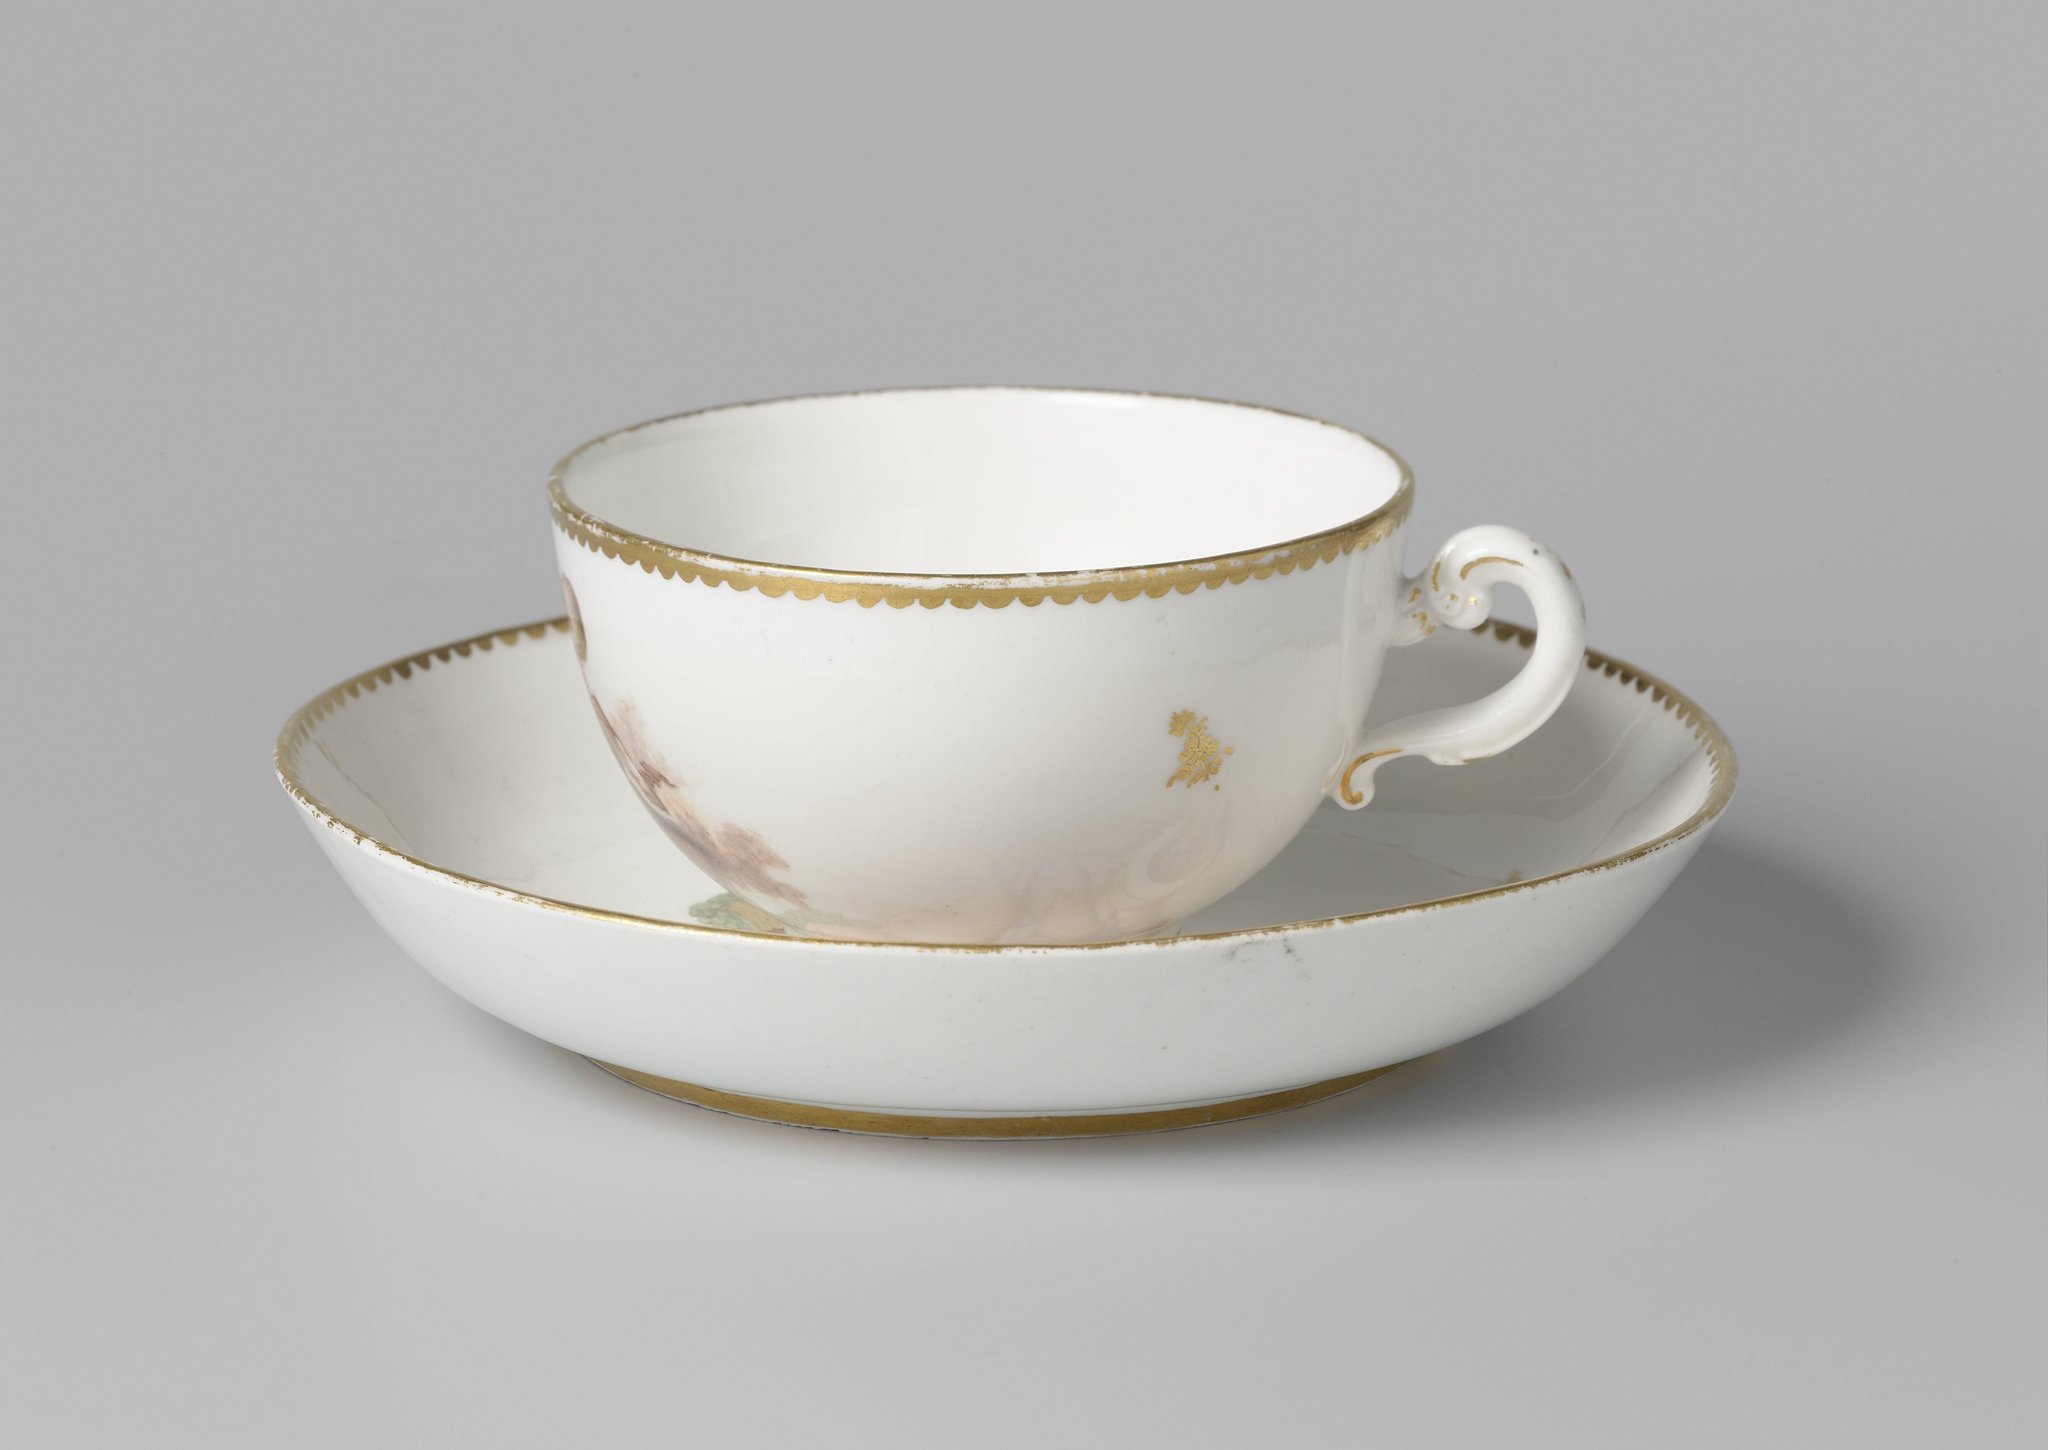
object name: cup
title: Kop, beschilderd met een putto met het wapen van Holland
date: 1774-1778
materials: porcelain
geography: loosdrecht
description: Tea cup and saucer. Porcelain. Loosdrecht, c. 1774 - 1780. Factory of Joannes de Mol. Given by the Belport Familien Stiftung, 1983.